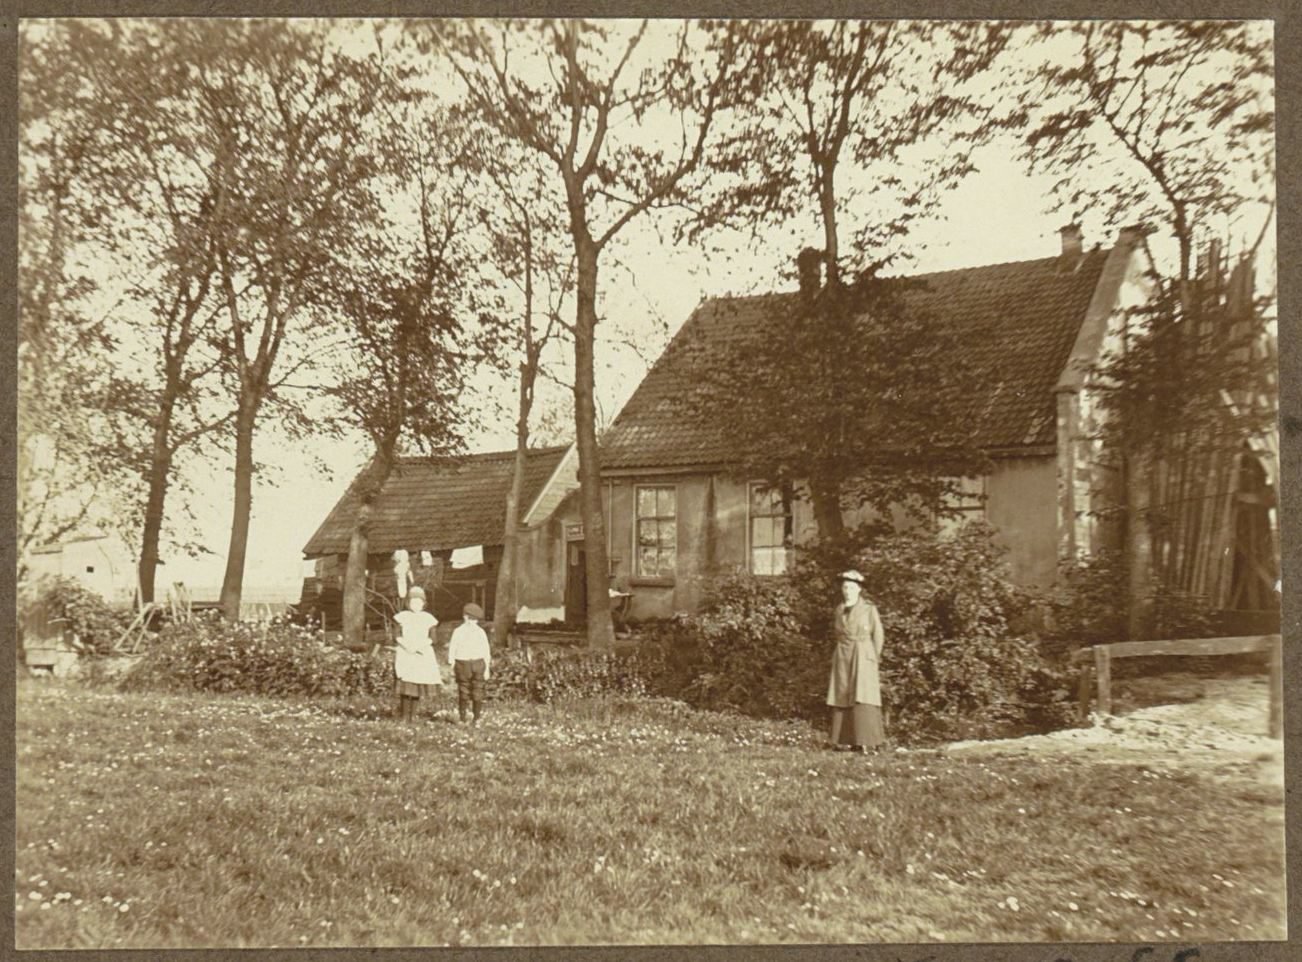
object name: photograph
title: Vrouw en twee kinderen bij een huisje, in de buurt van een Amsterdams stadion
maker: Anonymous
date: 1910-1930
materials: paper, photographic support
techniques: gelatin silver print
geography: amsterdam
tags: public gardens, park (+ city(-scape) with figures, staffage)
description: Onderdeel van Album met foto's van Amsterdam en omgeving.